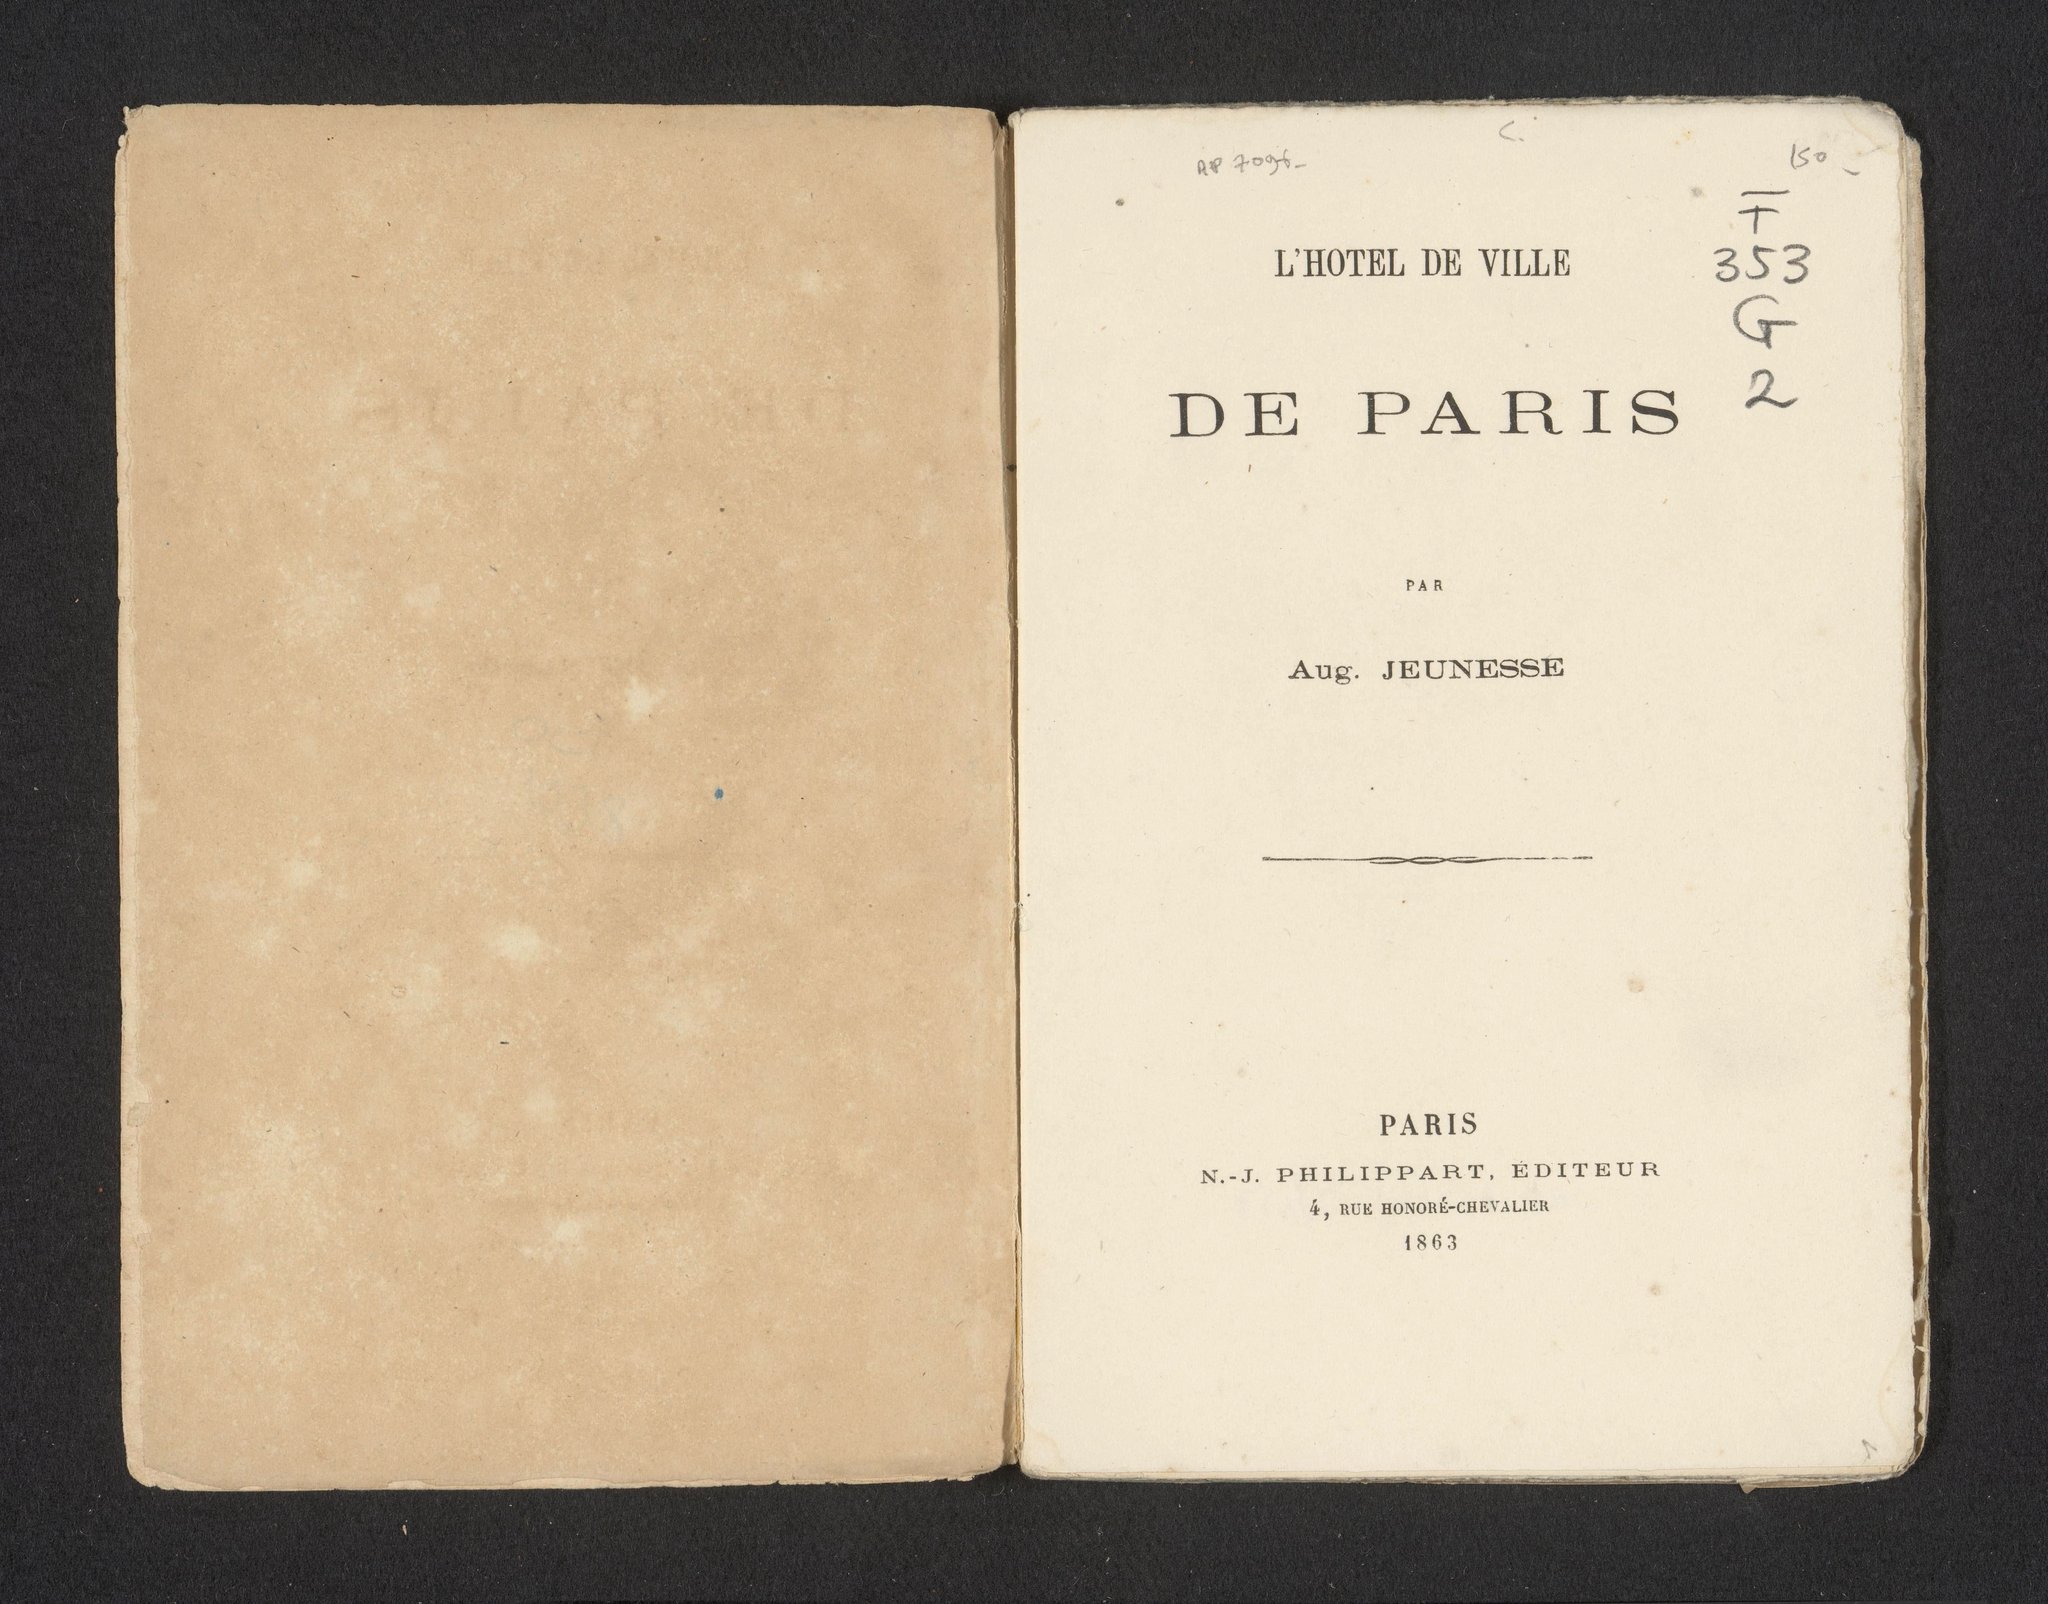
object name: book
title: Hôtel de Ville de Paris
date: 1863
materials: paper, photographic support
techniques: albumen print, printing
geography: paris